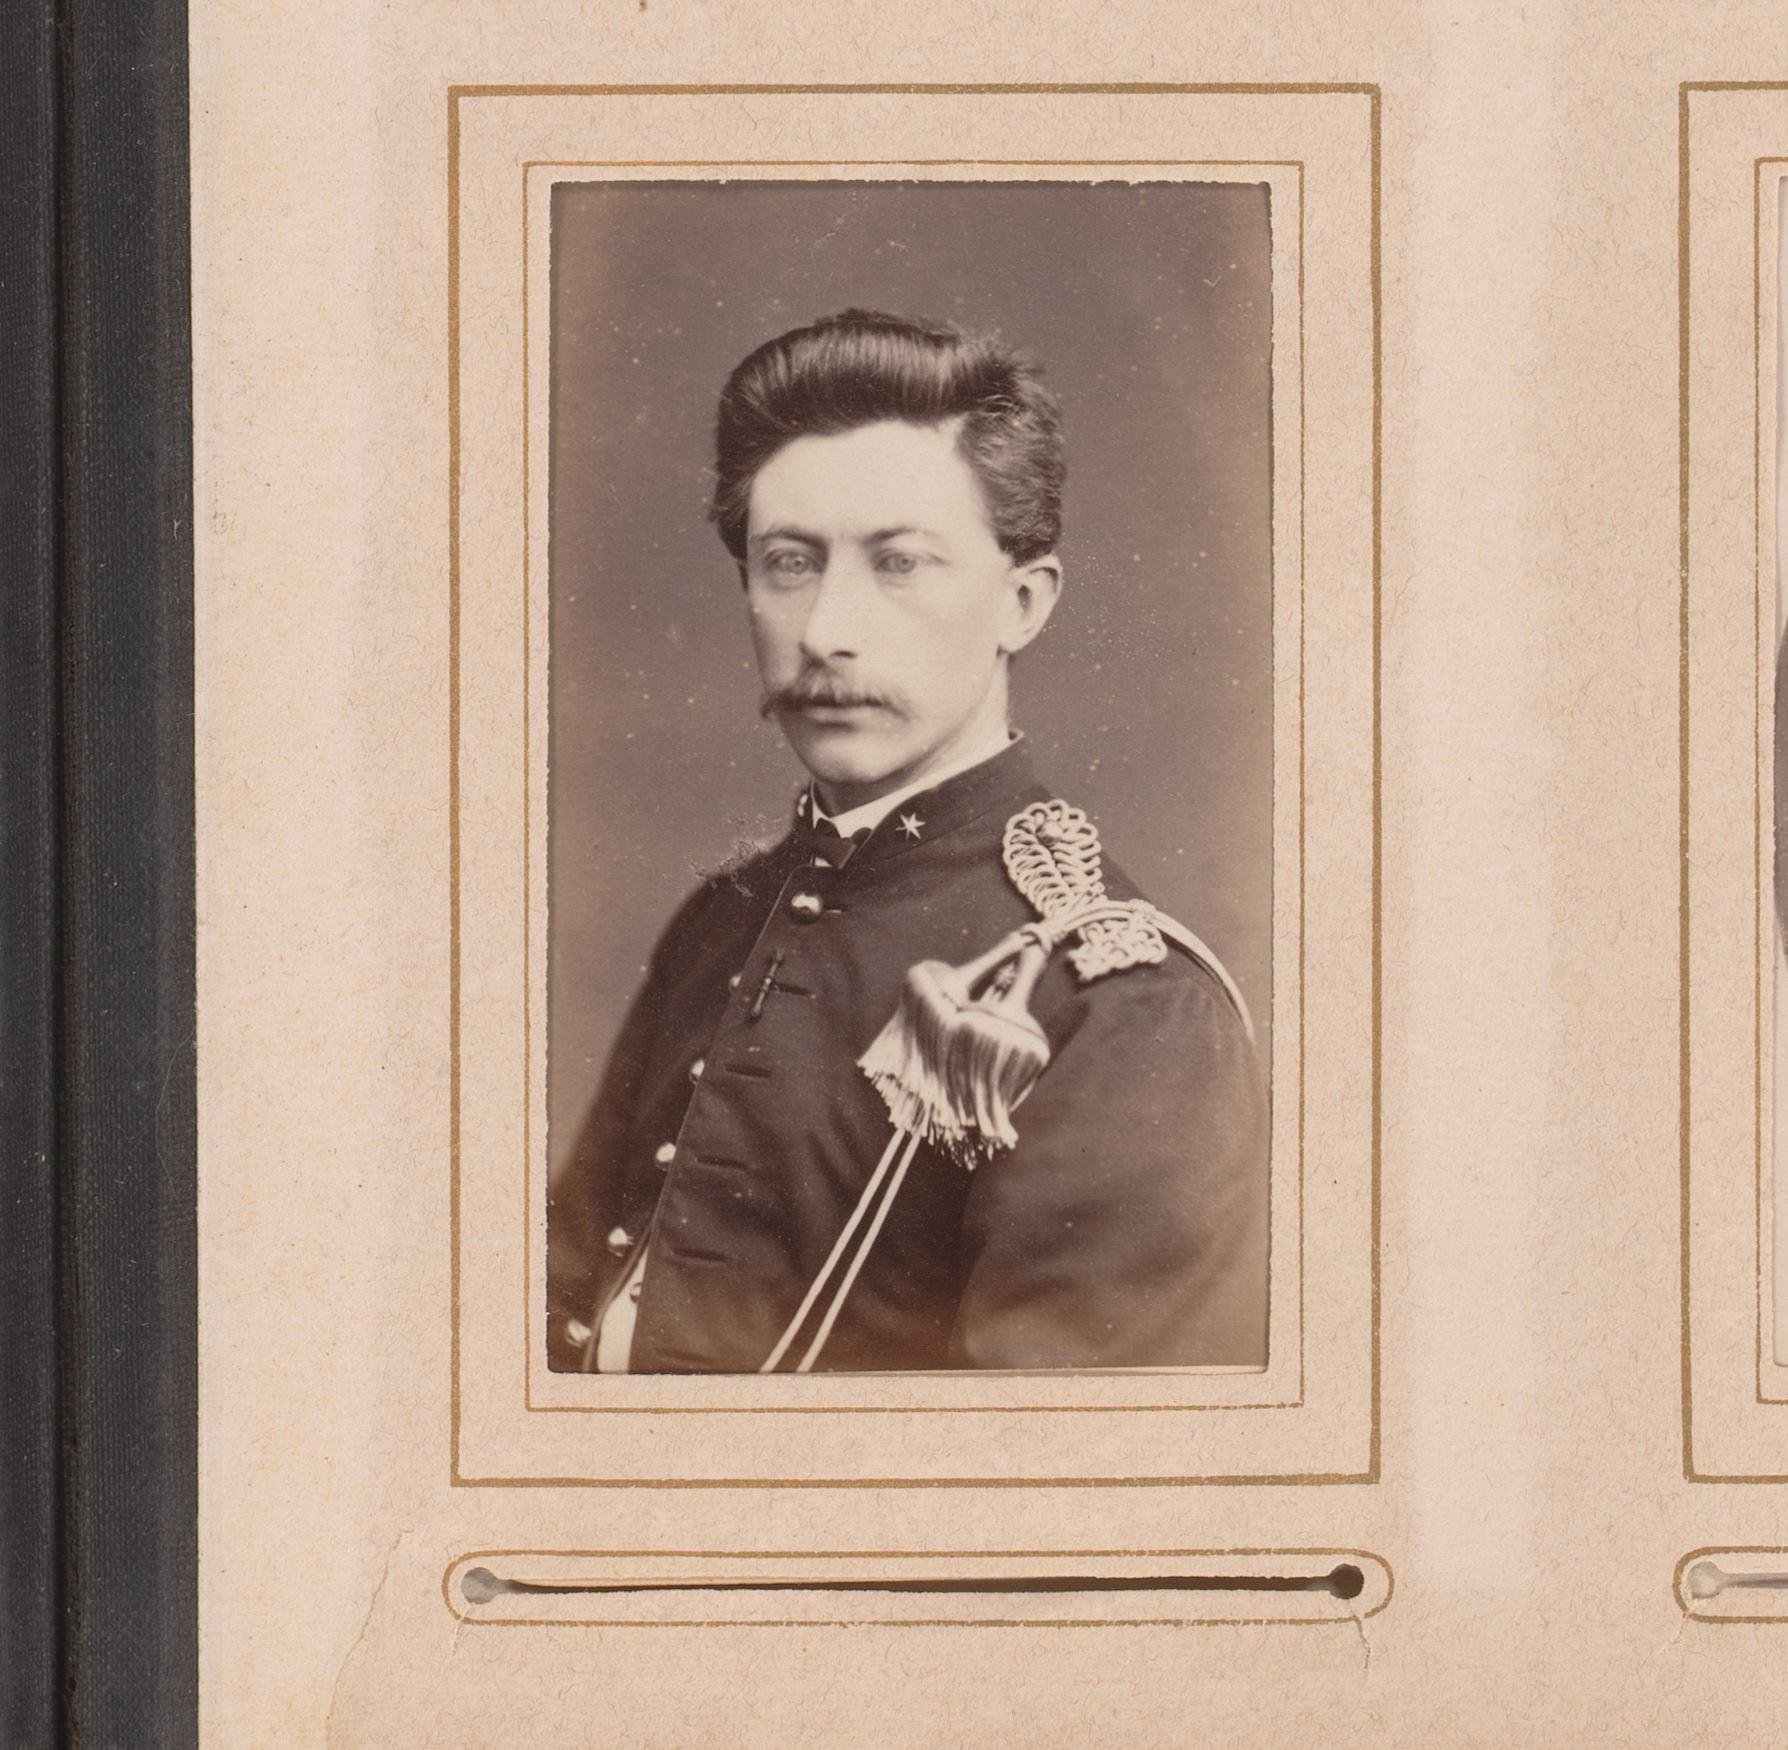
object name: carte de visite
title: Portret van een man met snor in uniform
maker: albert greiner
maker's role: fotograaf, fotostudio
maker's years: 1833-1890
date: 1861-1874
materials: cardboard, photographic support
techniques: albumen print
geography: amsterdam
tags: moustache, historical persons, (military) uniforms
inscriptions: inscription: ‘A. Greiner/ Photograf/ Nieuwendijk L.87/ Amsterdam’